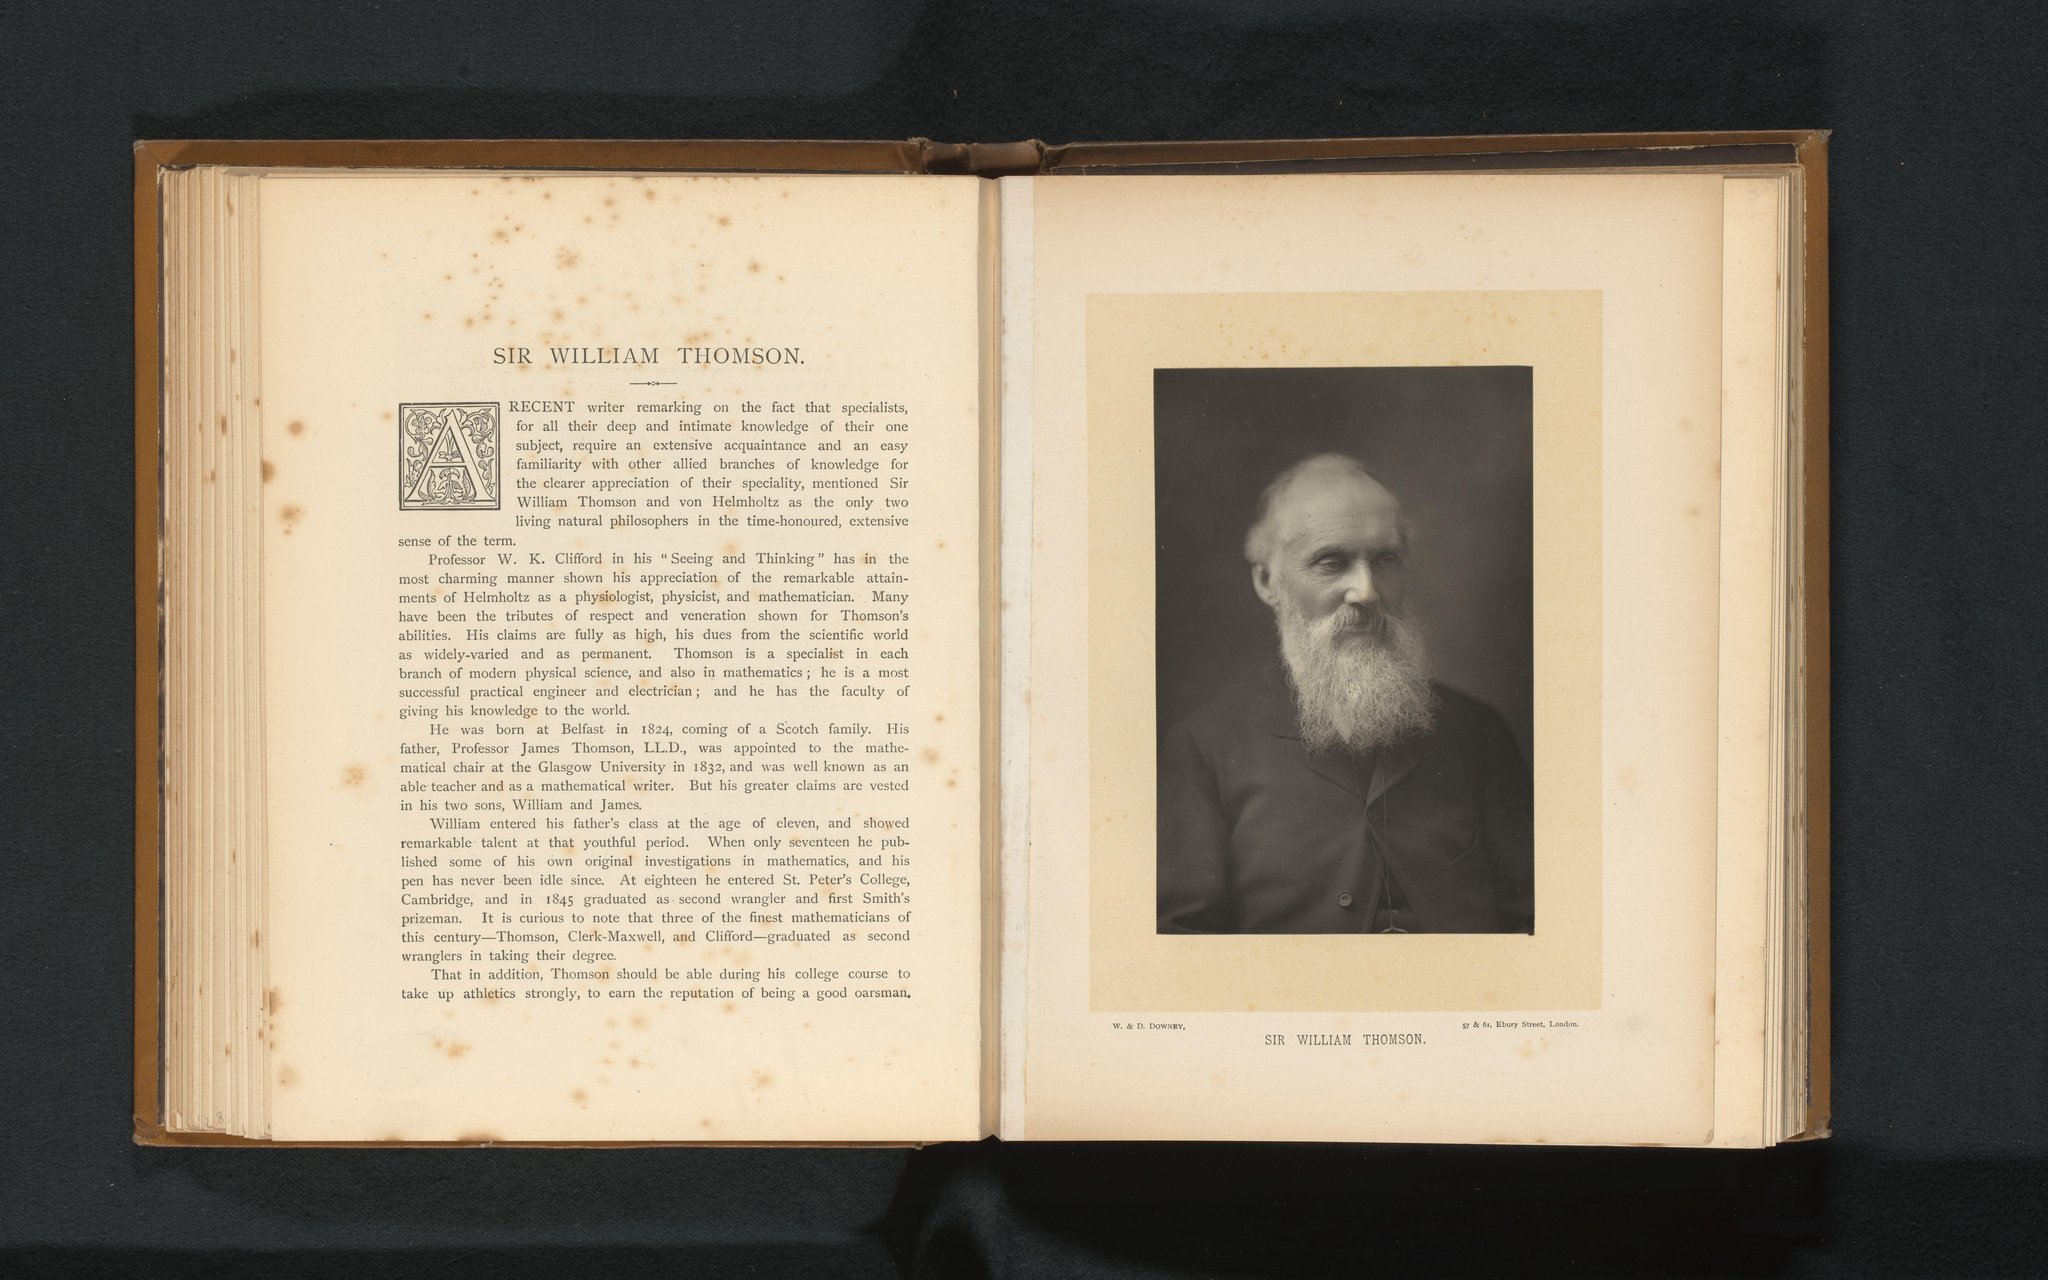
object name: photomechanical print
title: Portret van William Thomson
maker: Anonymous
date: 1882-1892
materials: paper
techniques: woodburytype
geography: london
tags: physicist, engineering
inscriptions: inscription: ‘57 & 61, Elbury Street, London.’